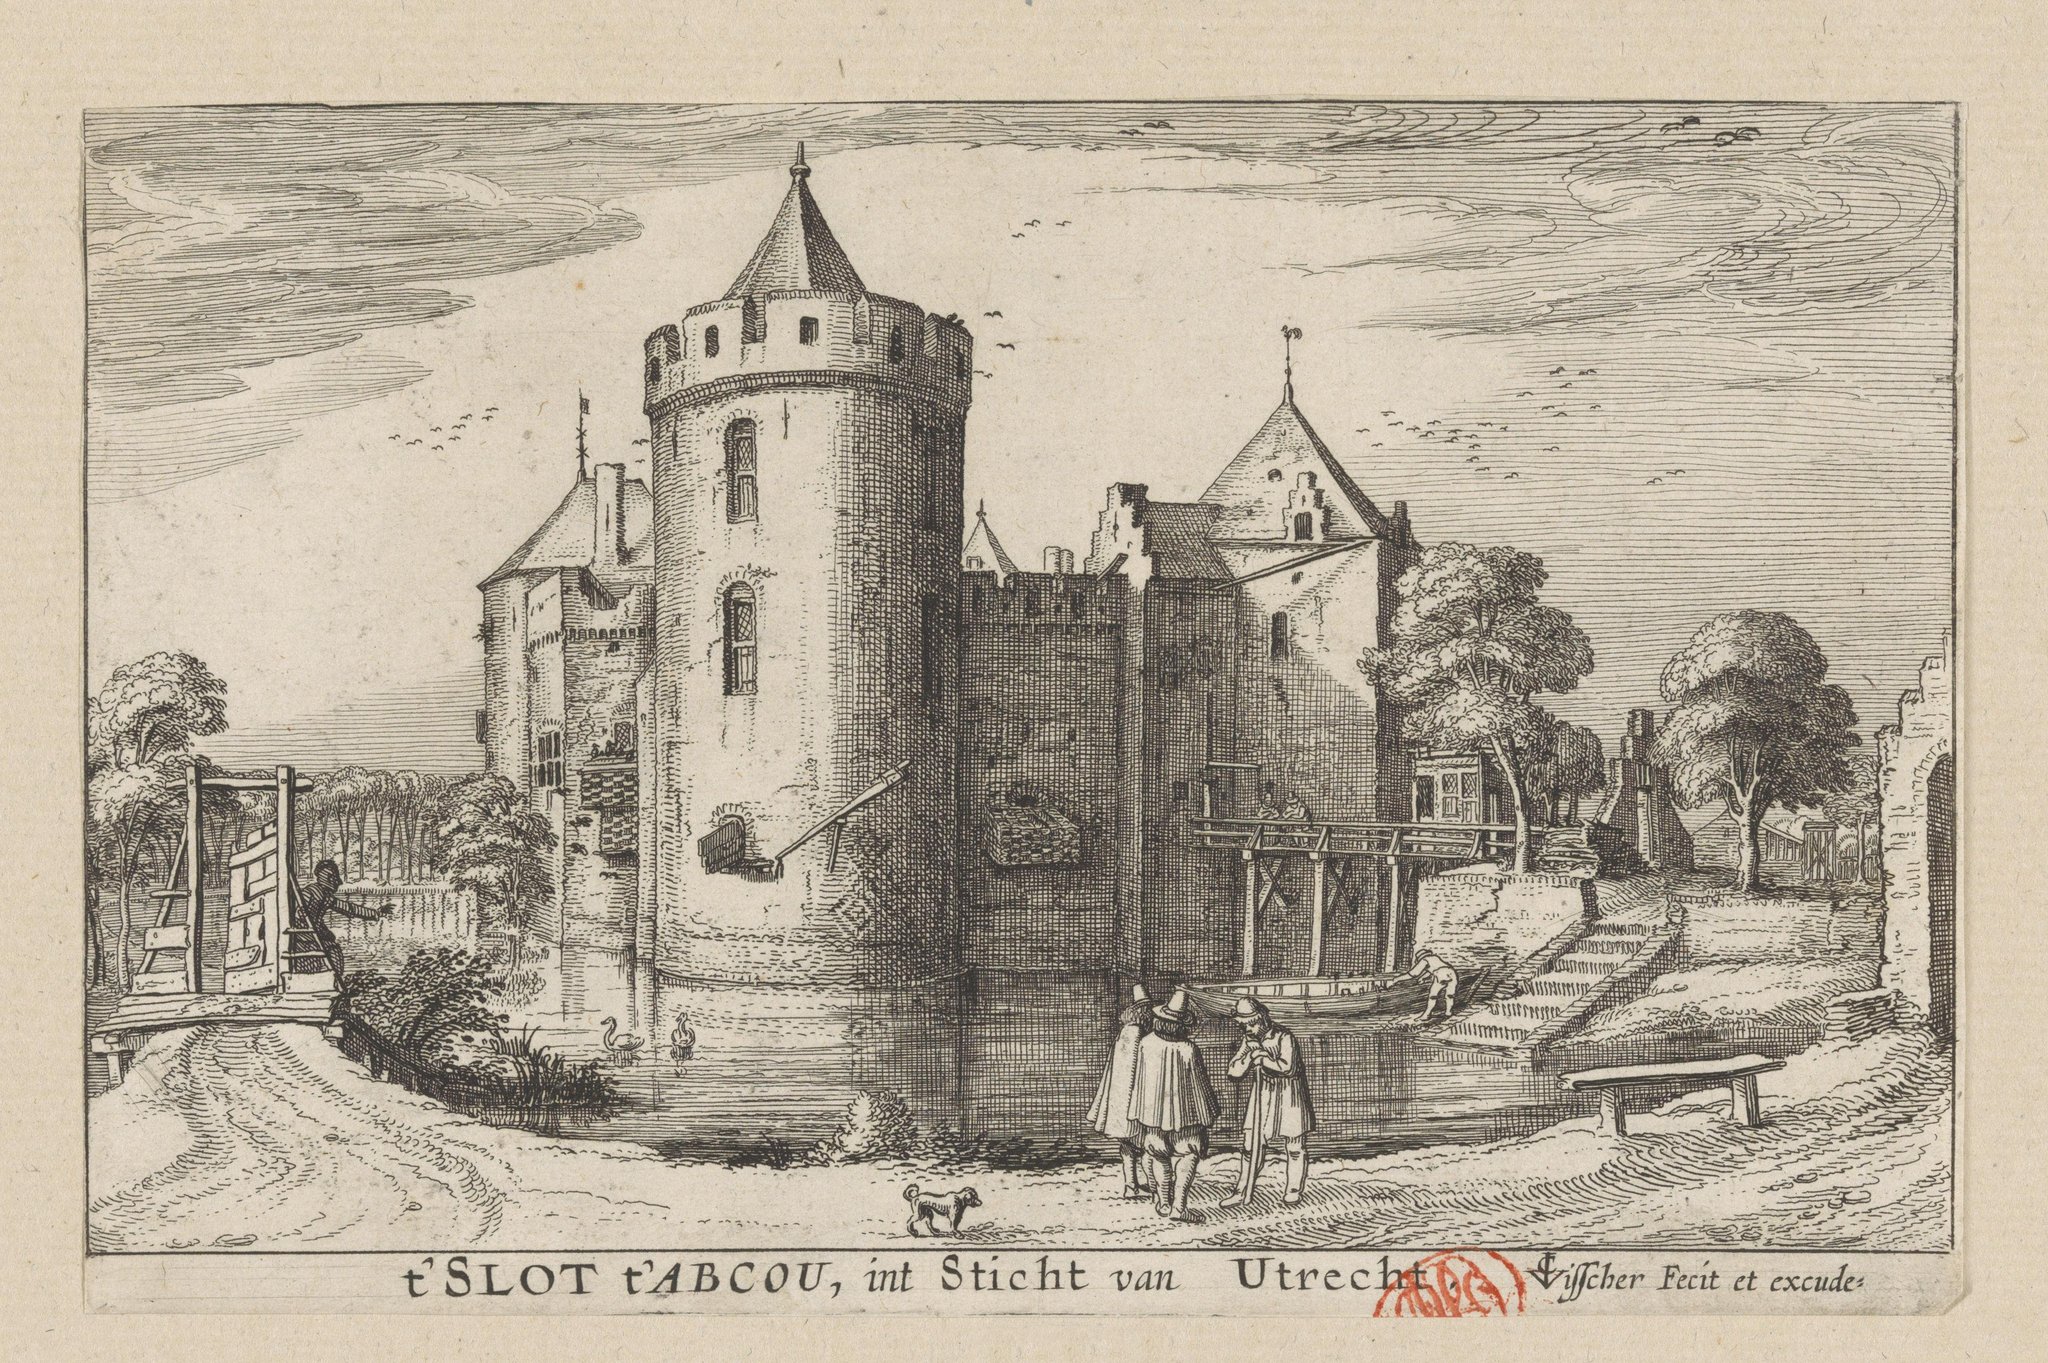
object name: print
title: t' Slot t' Abcou, int Sticht van Utrecht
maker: claes jansz. visscher (ii)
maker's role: draughtsman, print maker, publisher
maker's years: 1586-1652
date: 1617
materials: paper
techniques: engraving, etching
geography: amsterdam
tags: castle, conversation, dialogue; conversation piece, dog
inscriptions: collector's mark: Lugt 195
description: Landschap met Slot Abcoude. Op de voorgrond drie figuren en een hond. Derde prent in een serie van vier met kastelen te Holland en Utrecht.